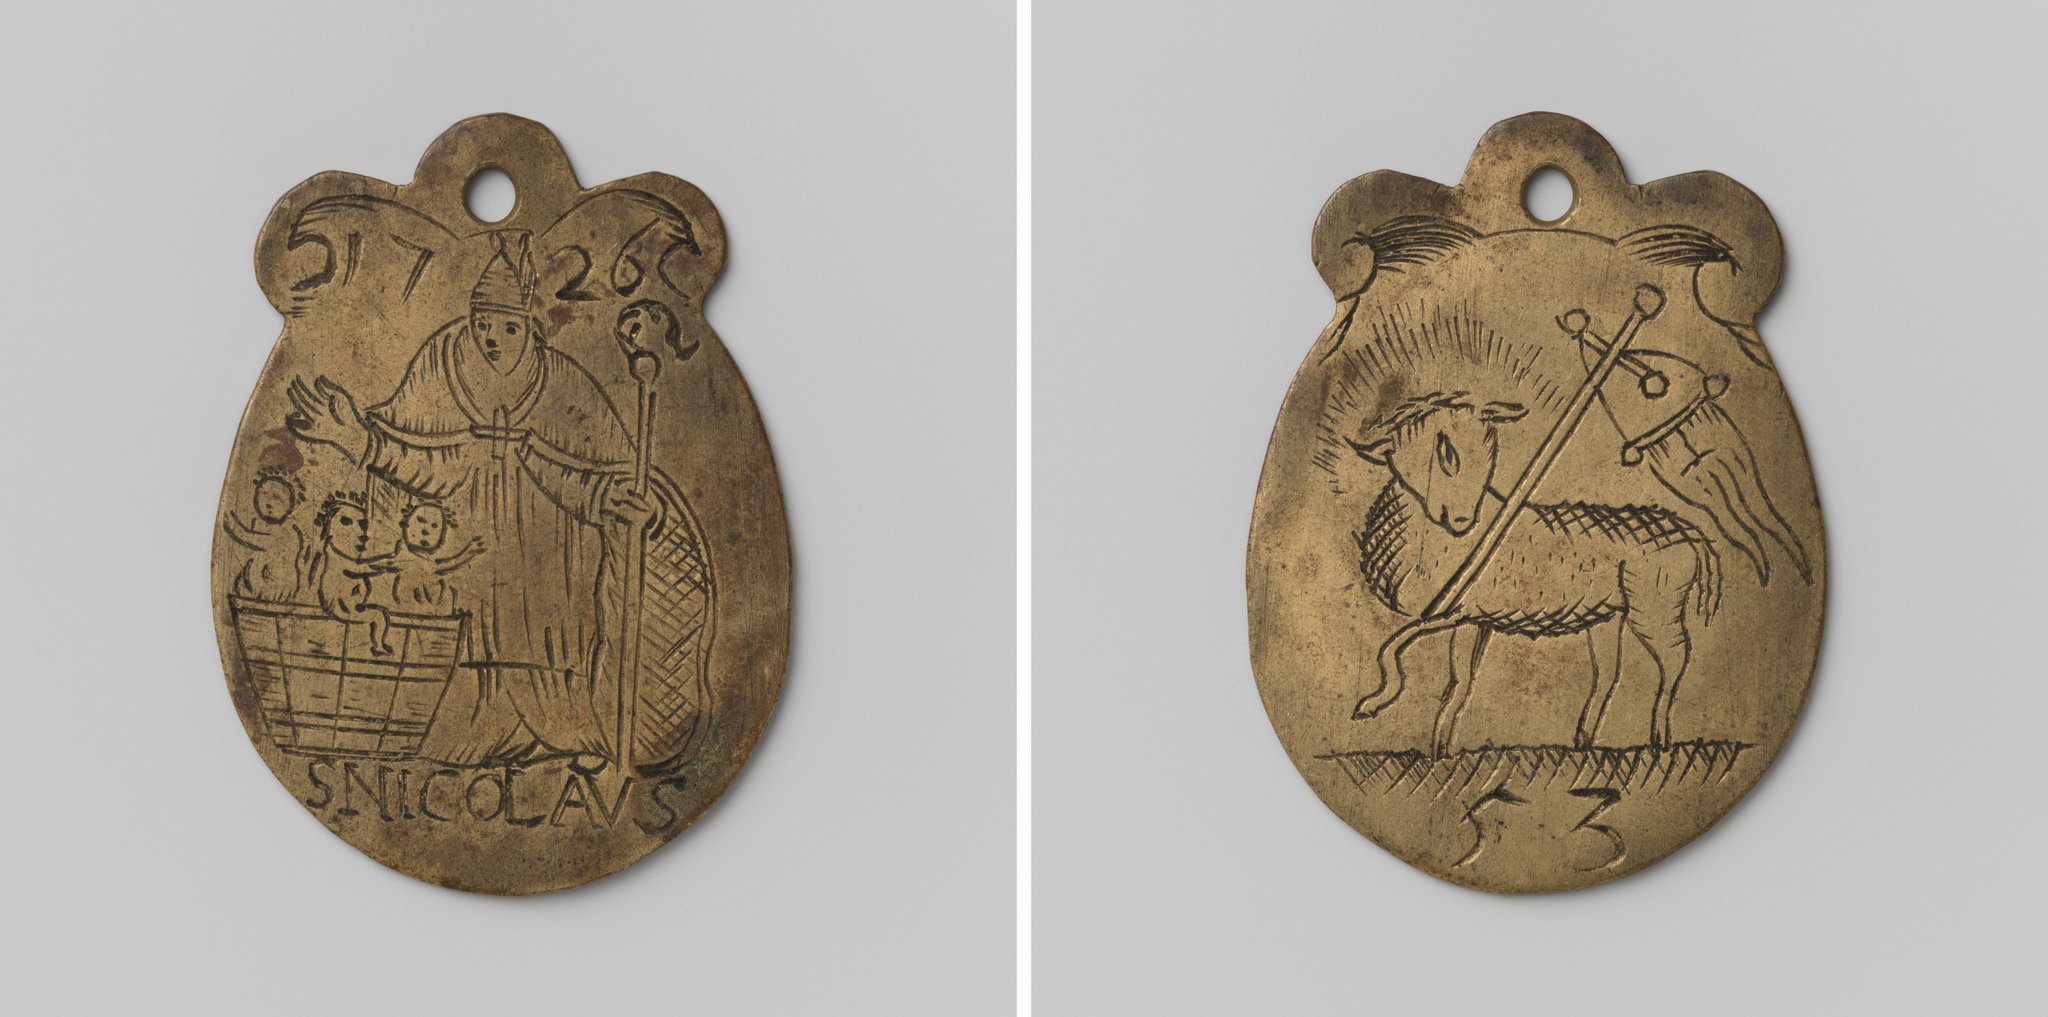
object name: medal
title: Kramers- of koopmansgilde van 's-Hertogenbosch, gildepenning met no. 53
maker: Anonymous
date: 1726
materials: brass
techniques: engraving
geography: den bosch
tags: den bosch